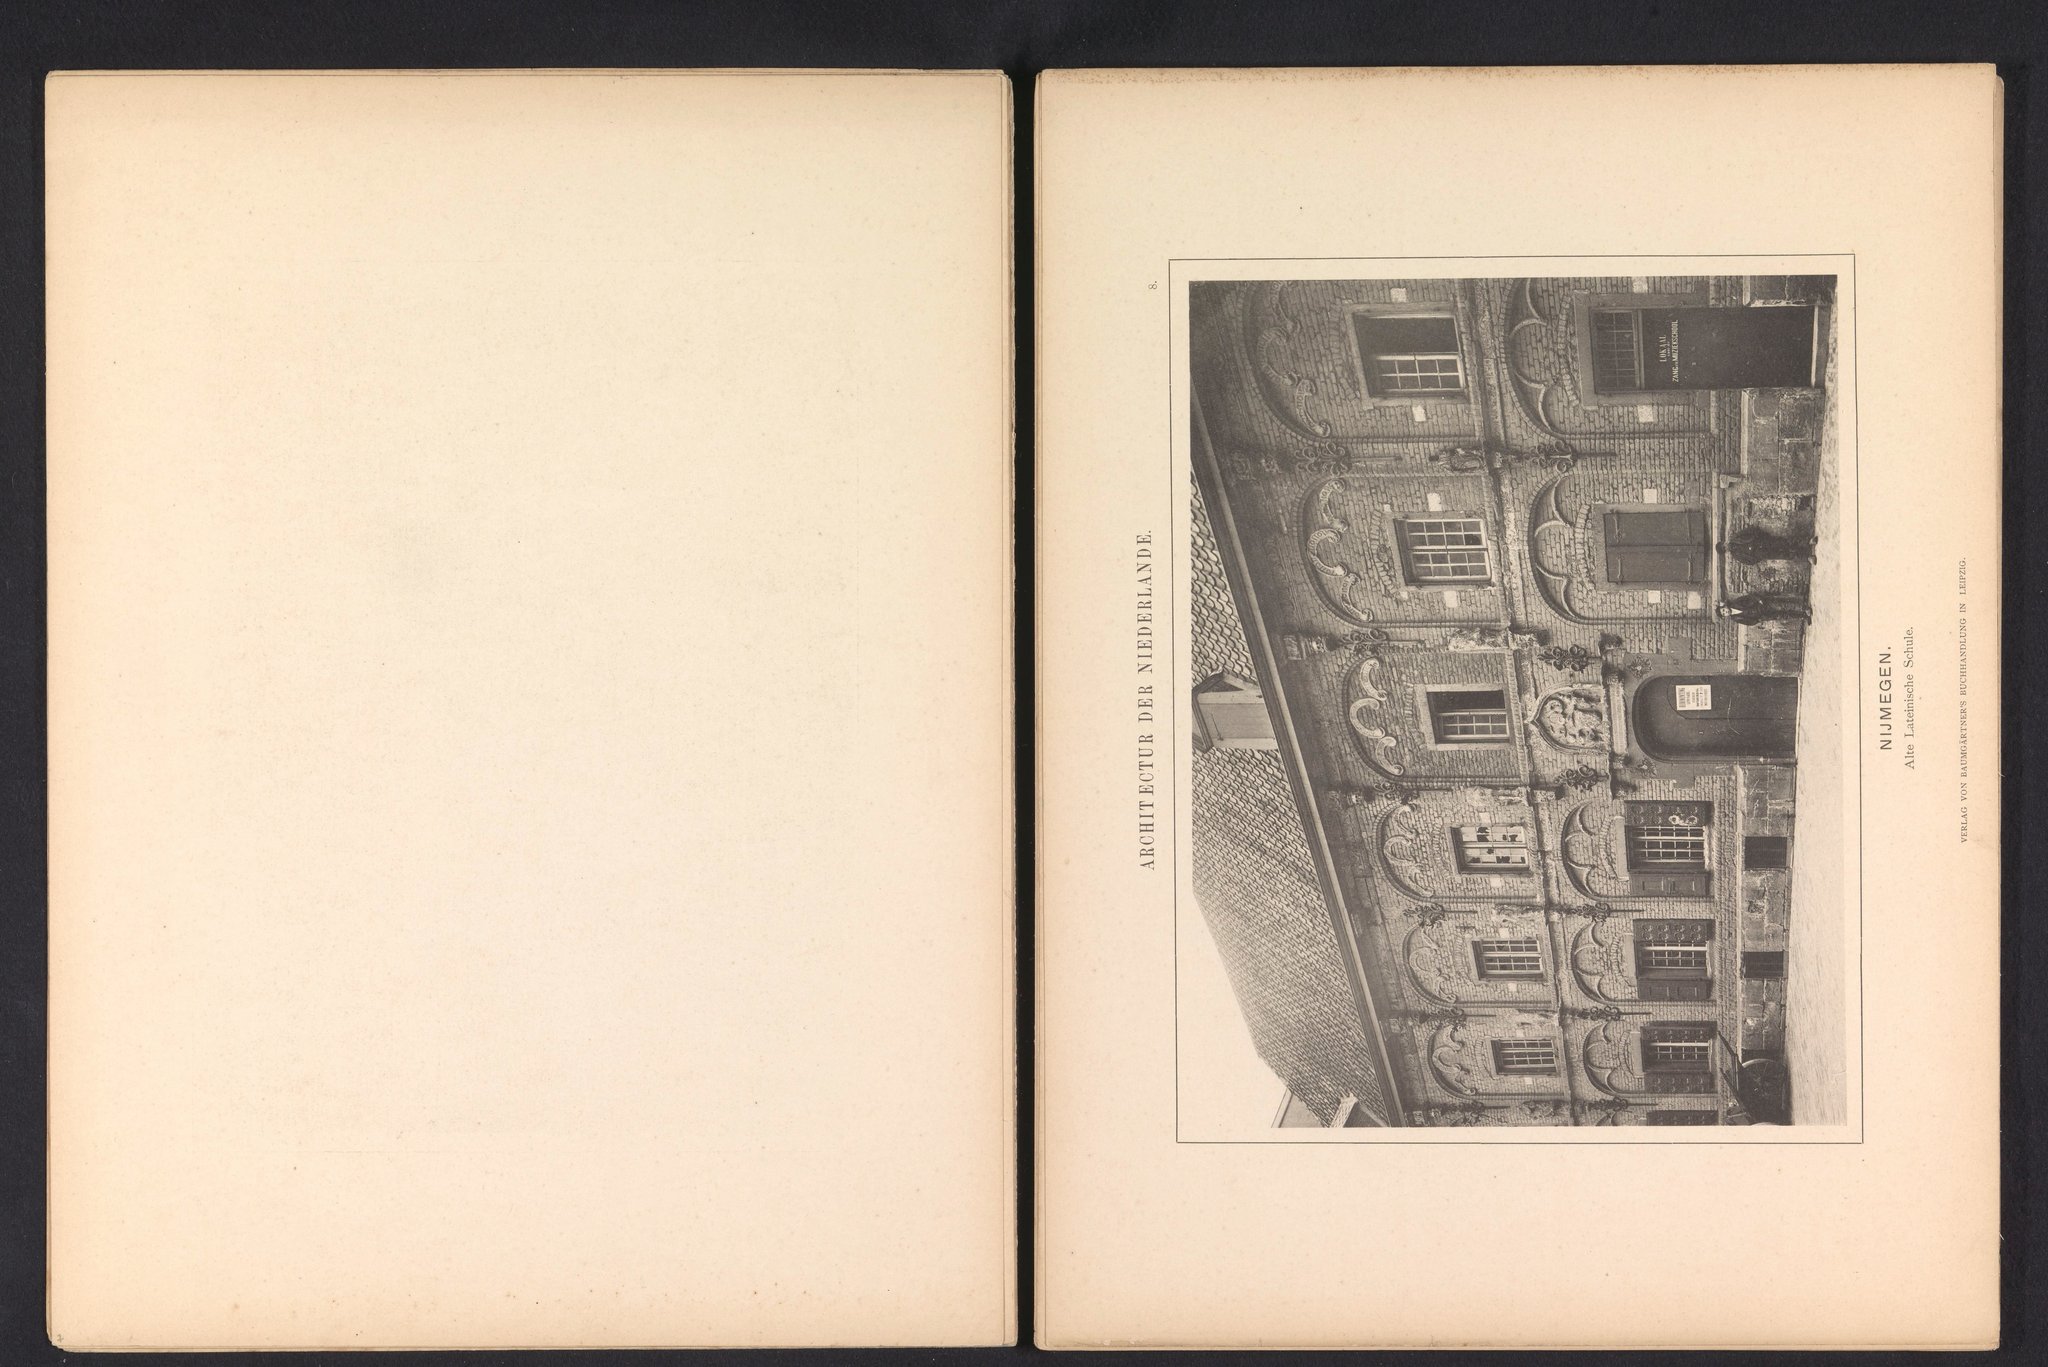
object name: page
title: Gezicht op de Latijnse School in Nijmegen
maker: Anonymous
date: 1884-1894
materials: paper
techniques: photograph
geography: leipzig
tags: façade (of house or building)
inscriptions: number: ‘8.’